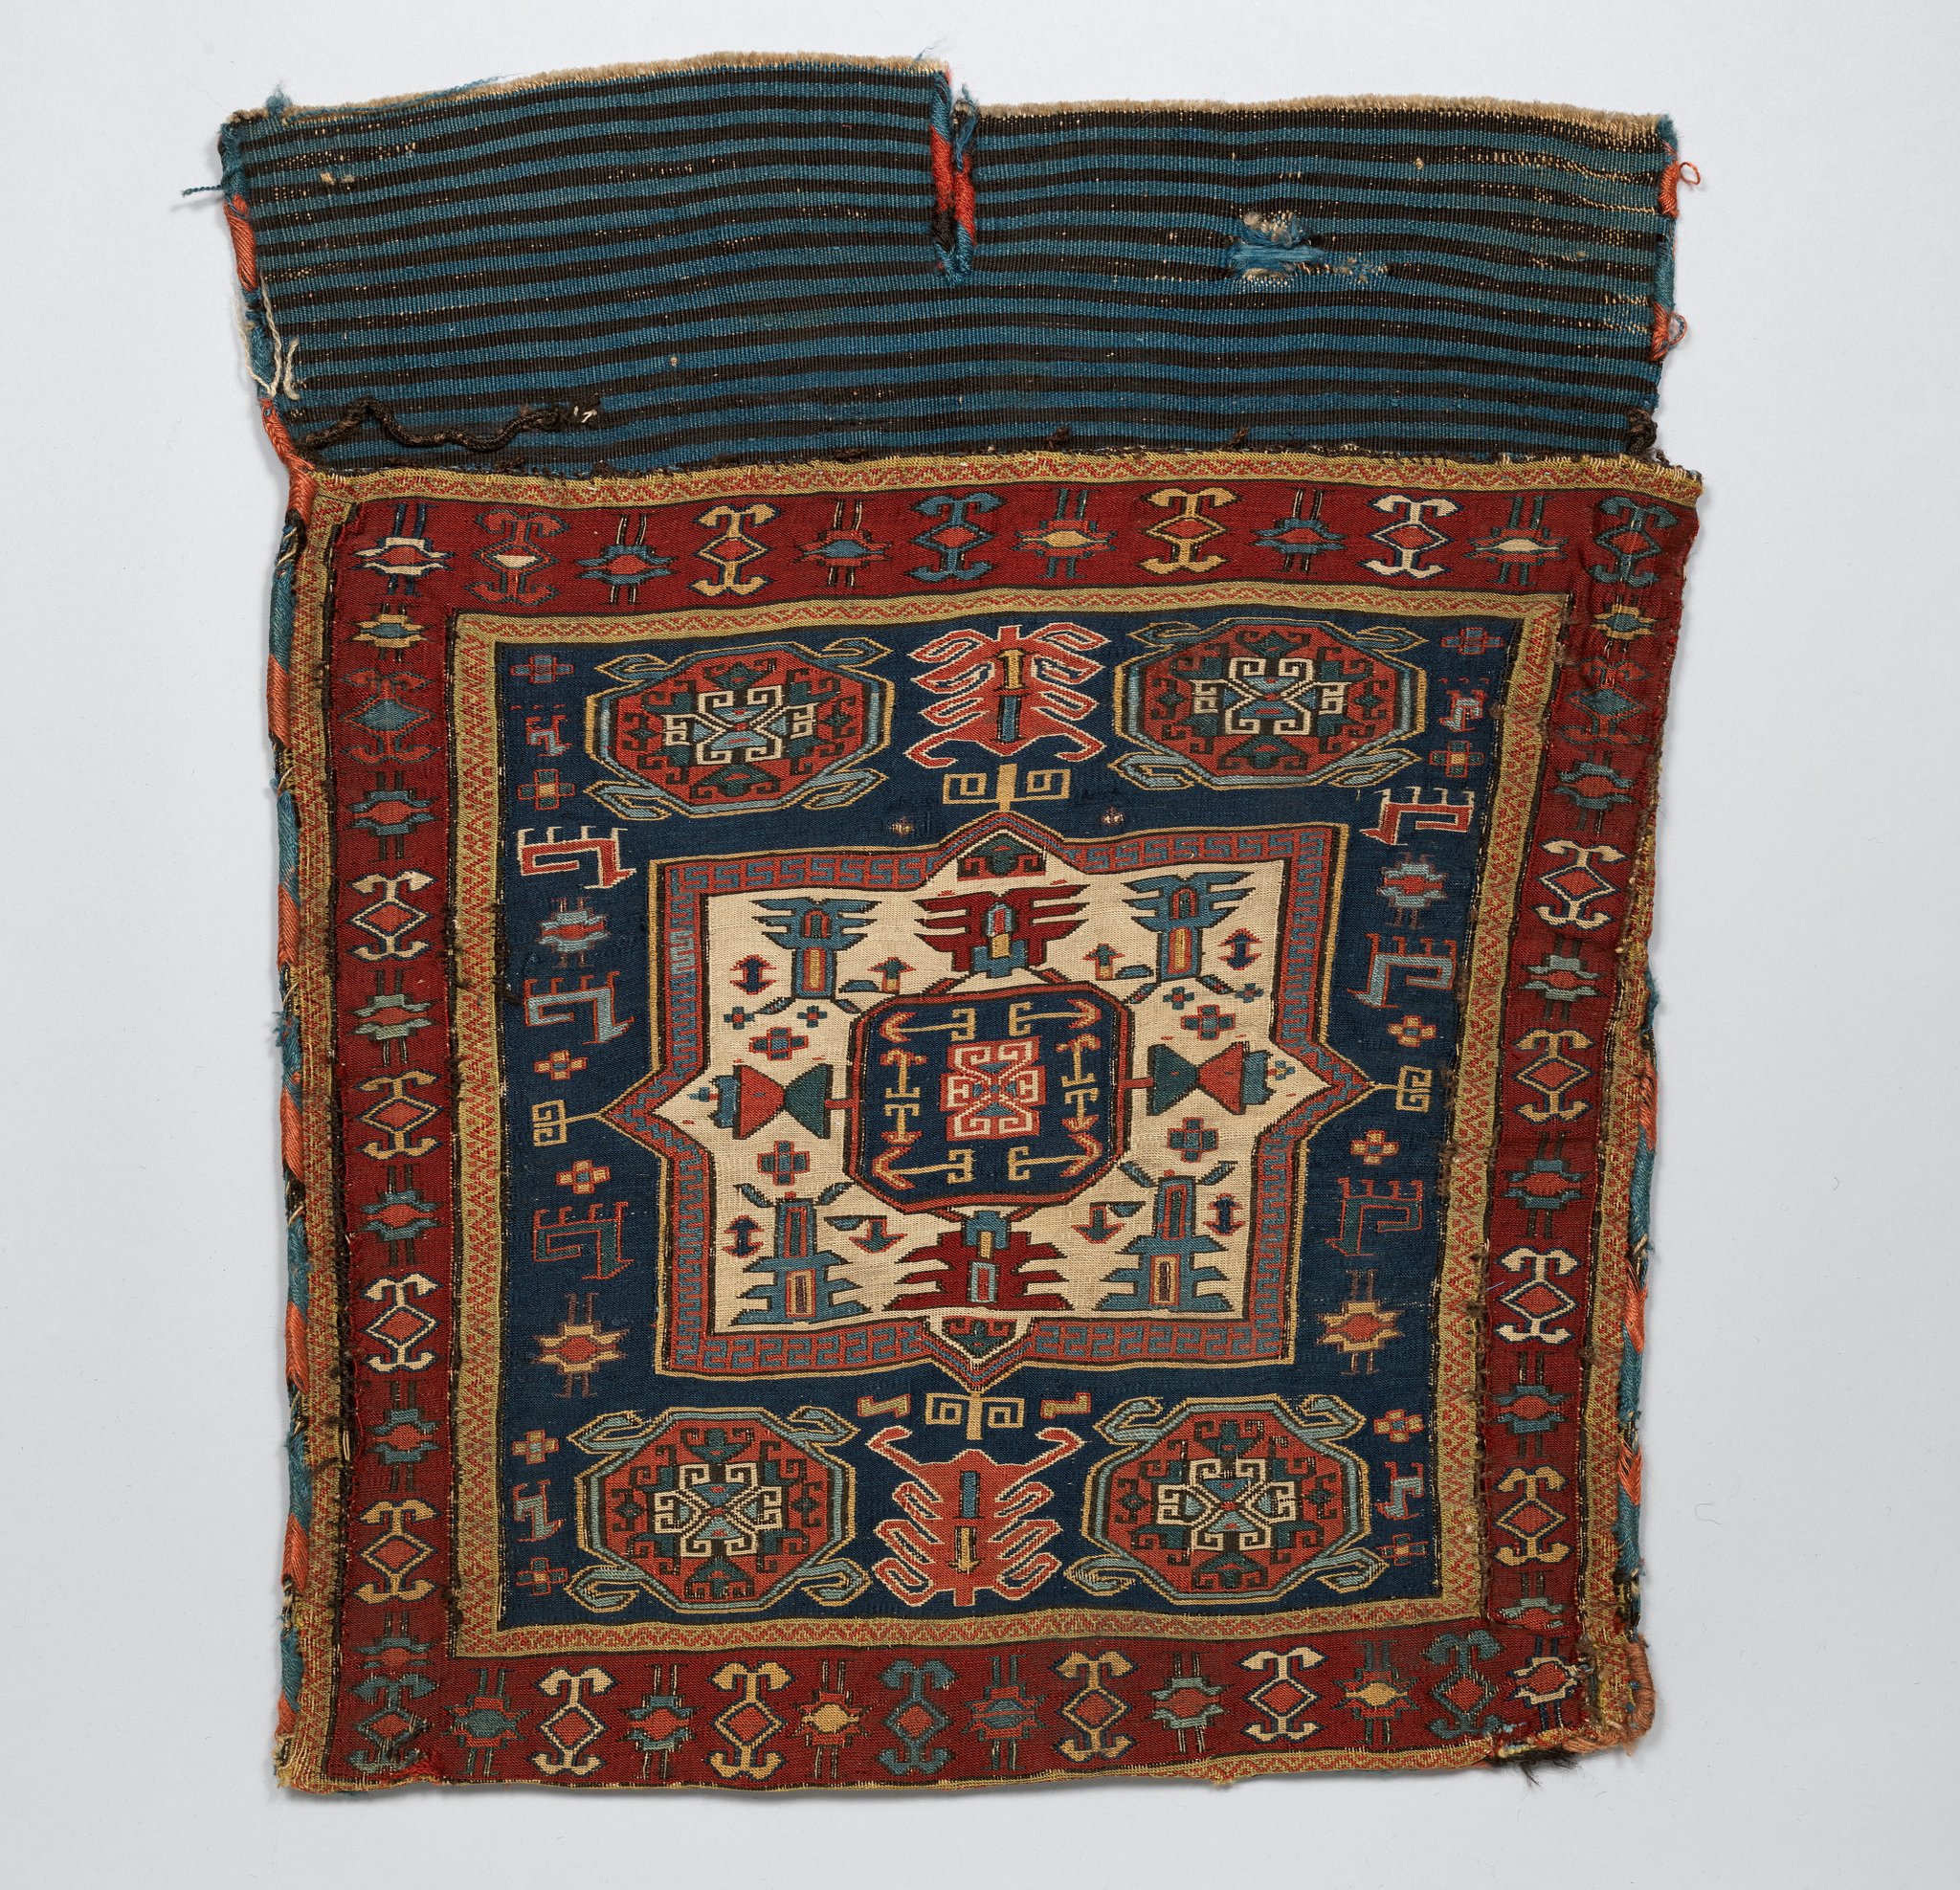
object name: saddle bag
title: Face of Half a Double Saddle Bag (Khorjin)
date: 1850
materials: wool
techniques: weave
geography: iran